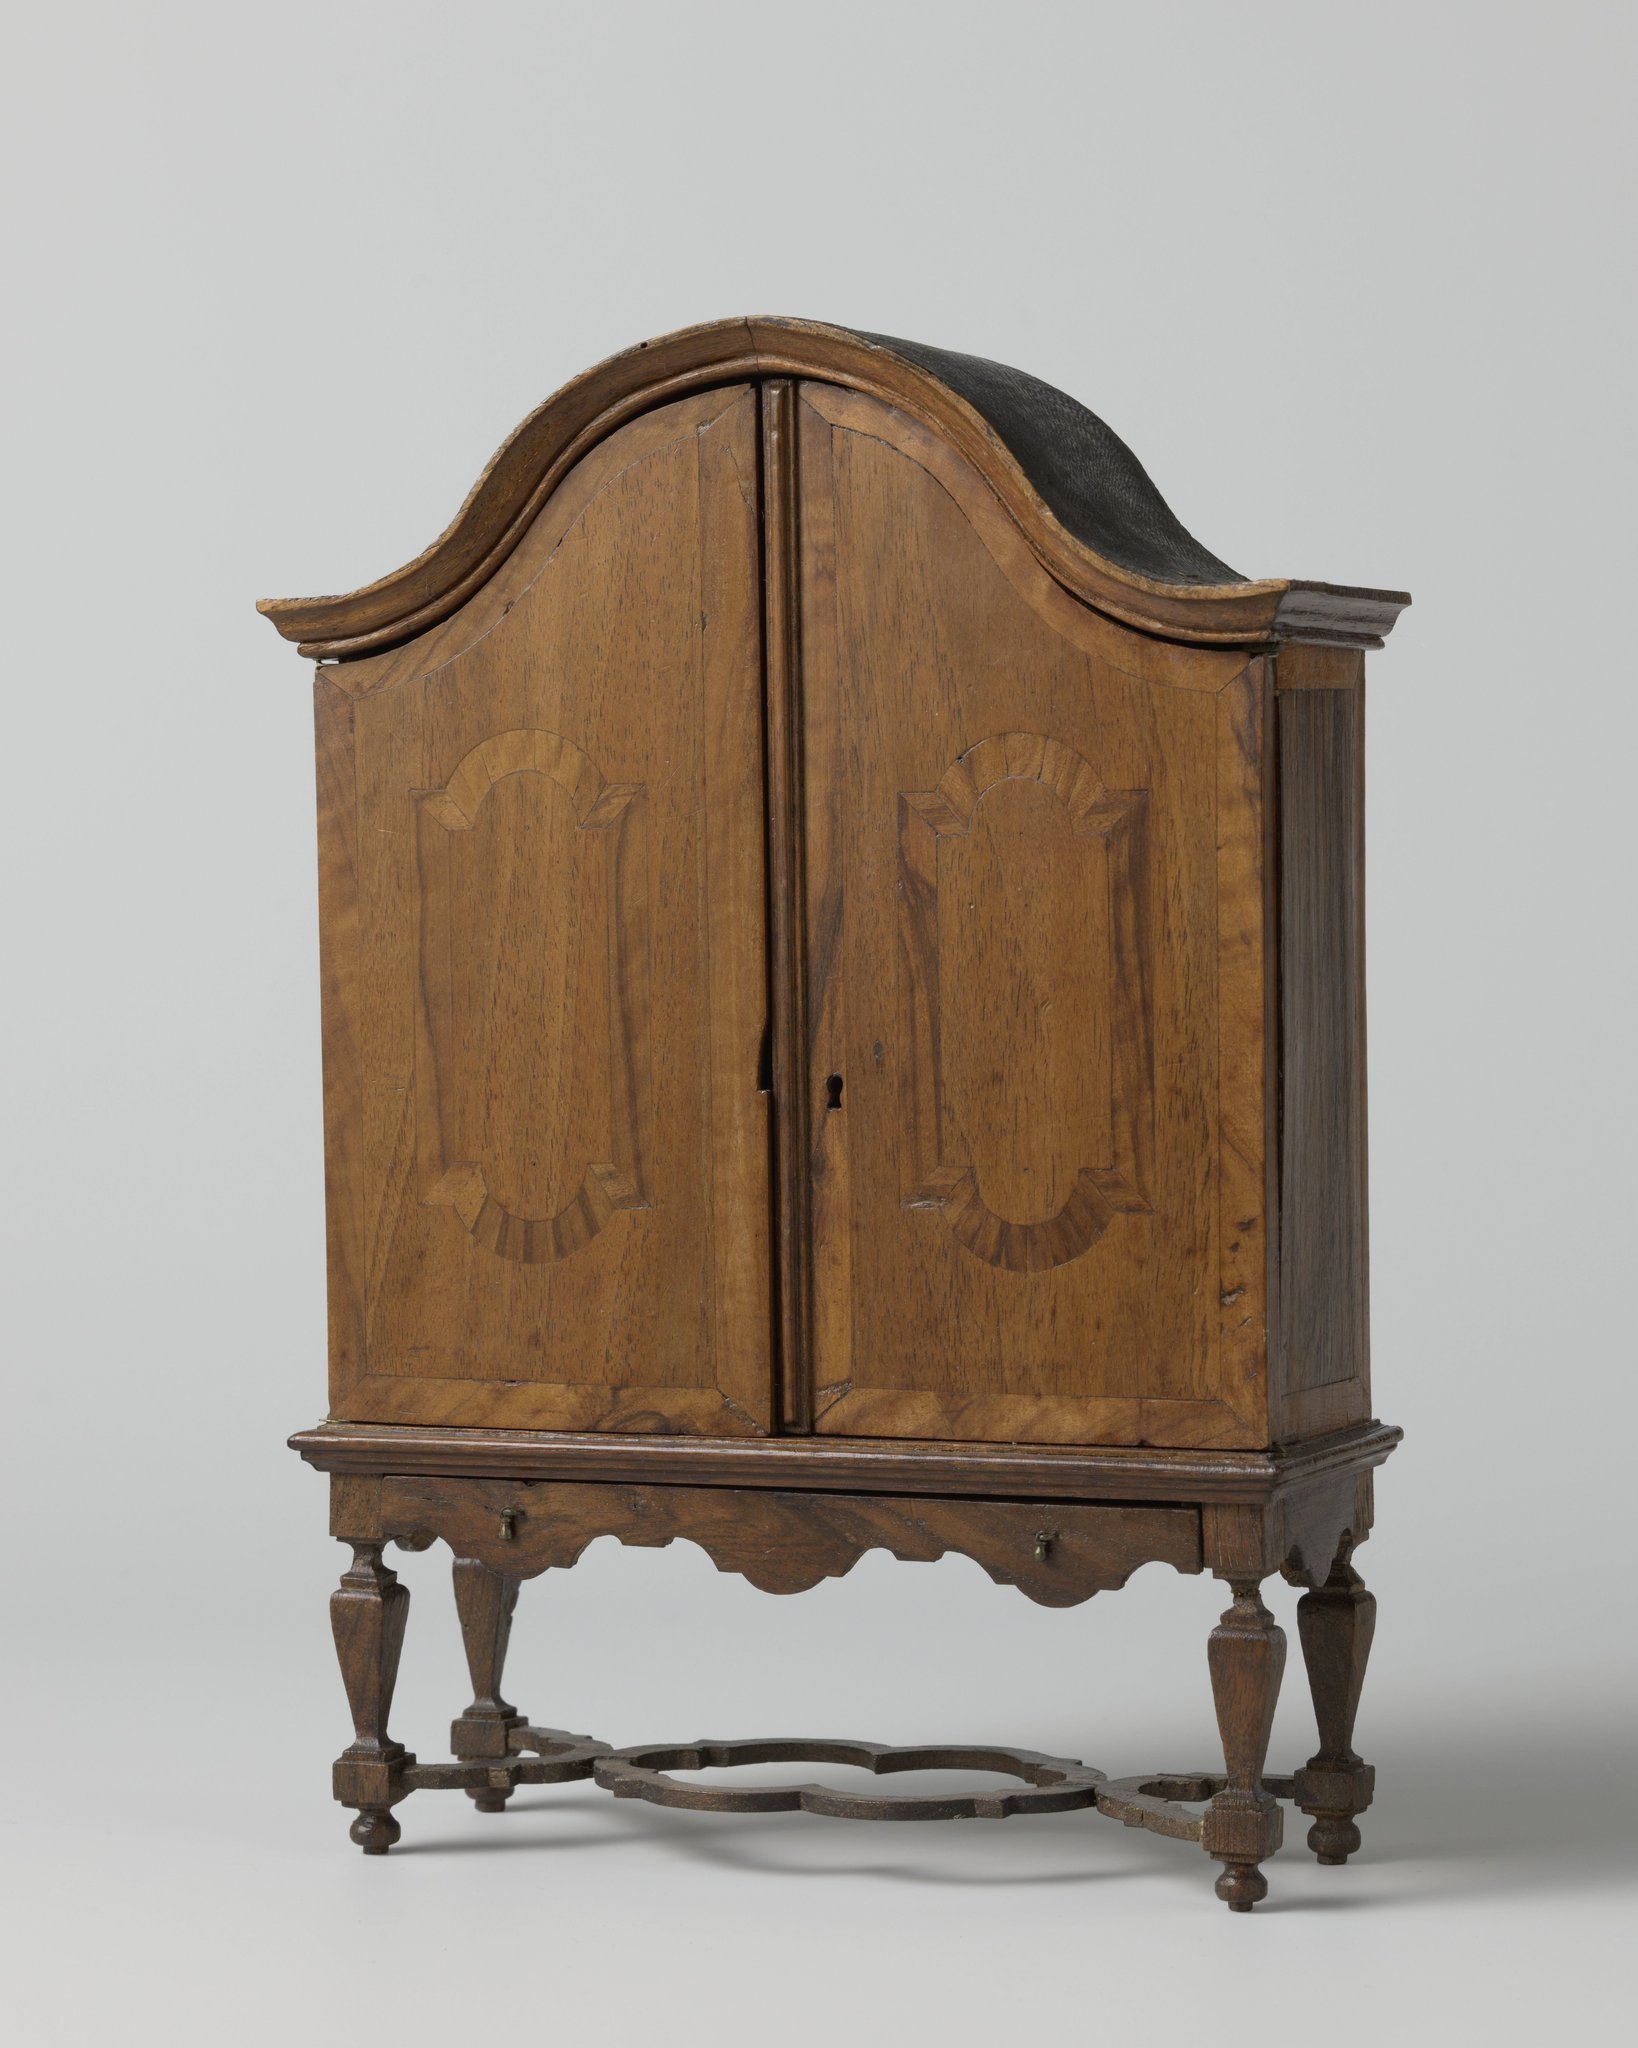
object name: miniature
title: Kabinet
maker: Anonymous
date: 1720-1740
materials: brass, wood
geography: amsterdam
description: Kabinet van eikenhout belijmd met notenhout, met twee deuren en een halfronde, geprofileerde uitstekende kap. Het kabinet staat op een onderstel met lade en rust op vier balustervormige poten met een golvende kruisverbinding.